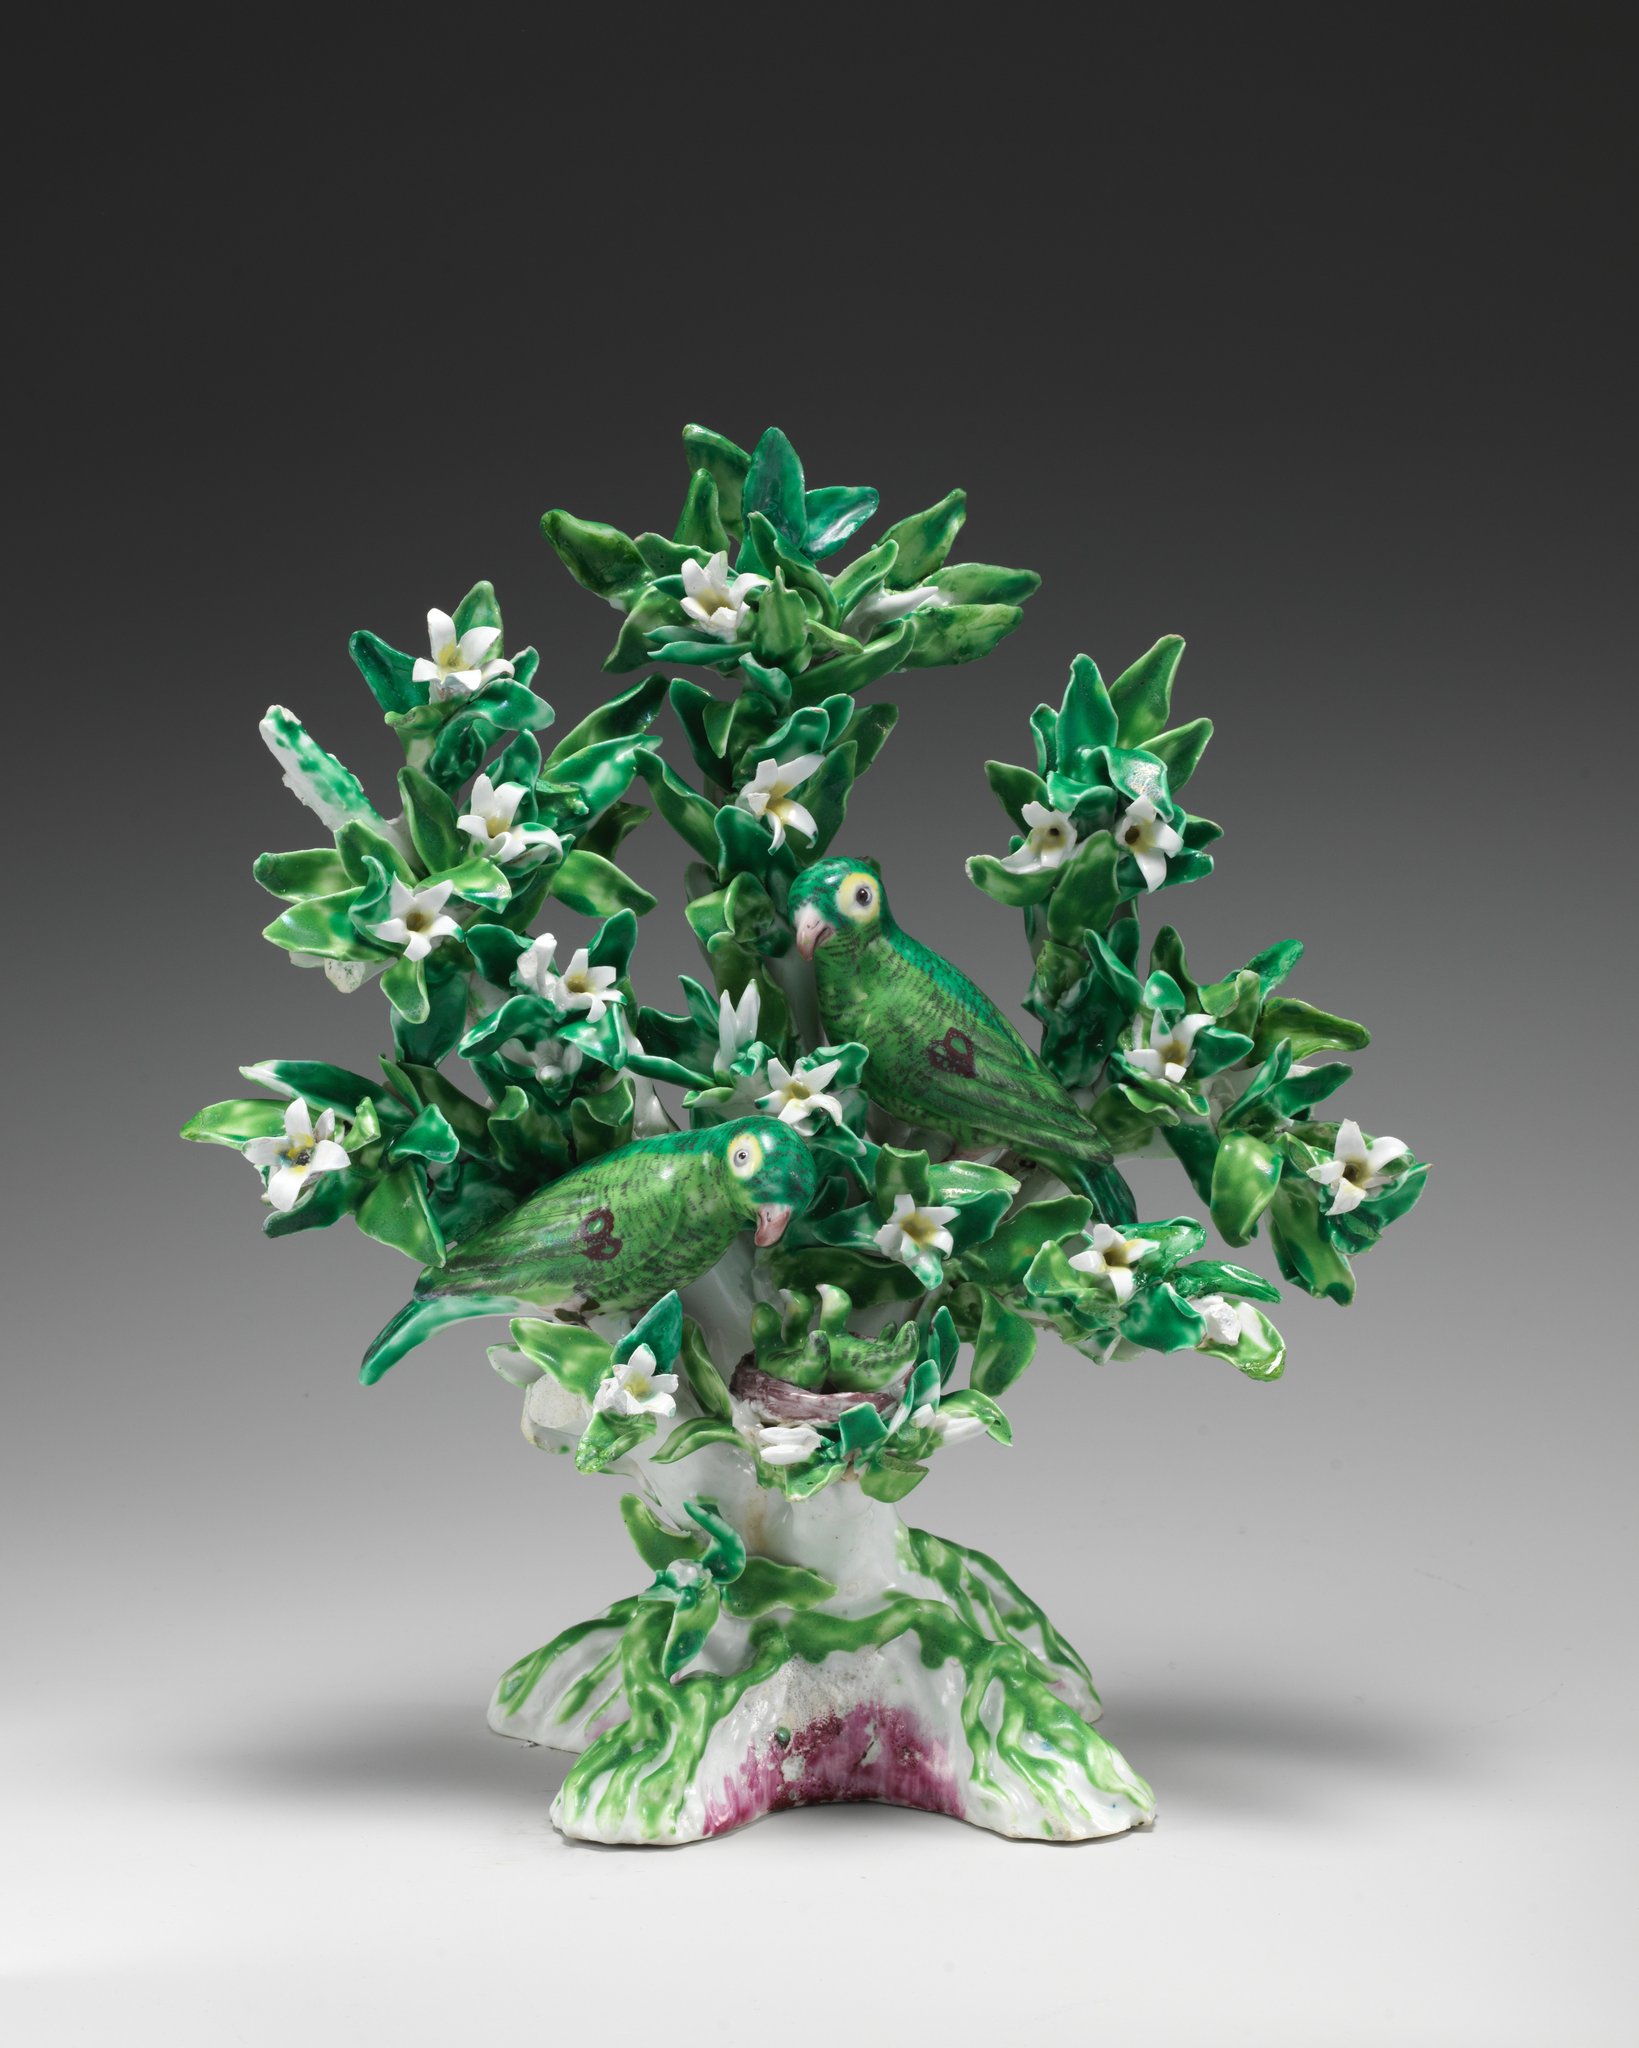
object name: group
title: Parrots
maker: bow porcelain factory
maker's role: factory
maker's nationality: british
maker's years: 1747-1776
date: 1755-1760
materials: soft paste porcelain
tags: parrots,flowers,leaves